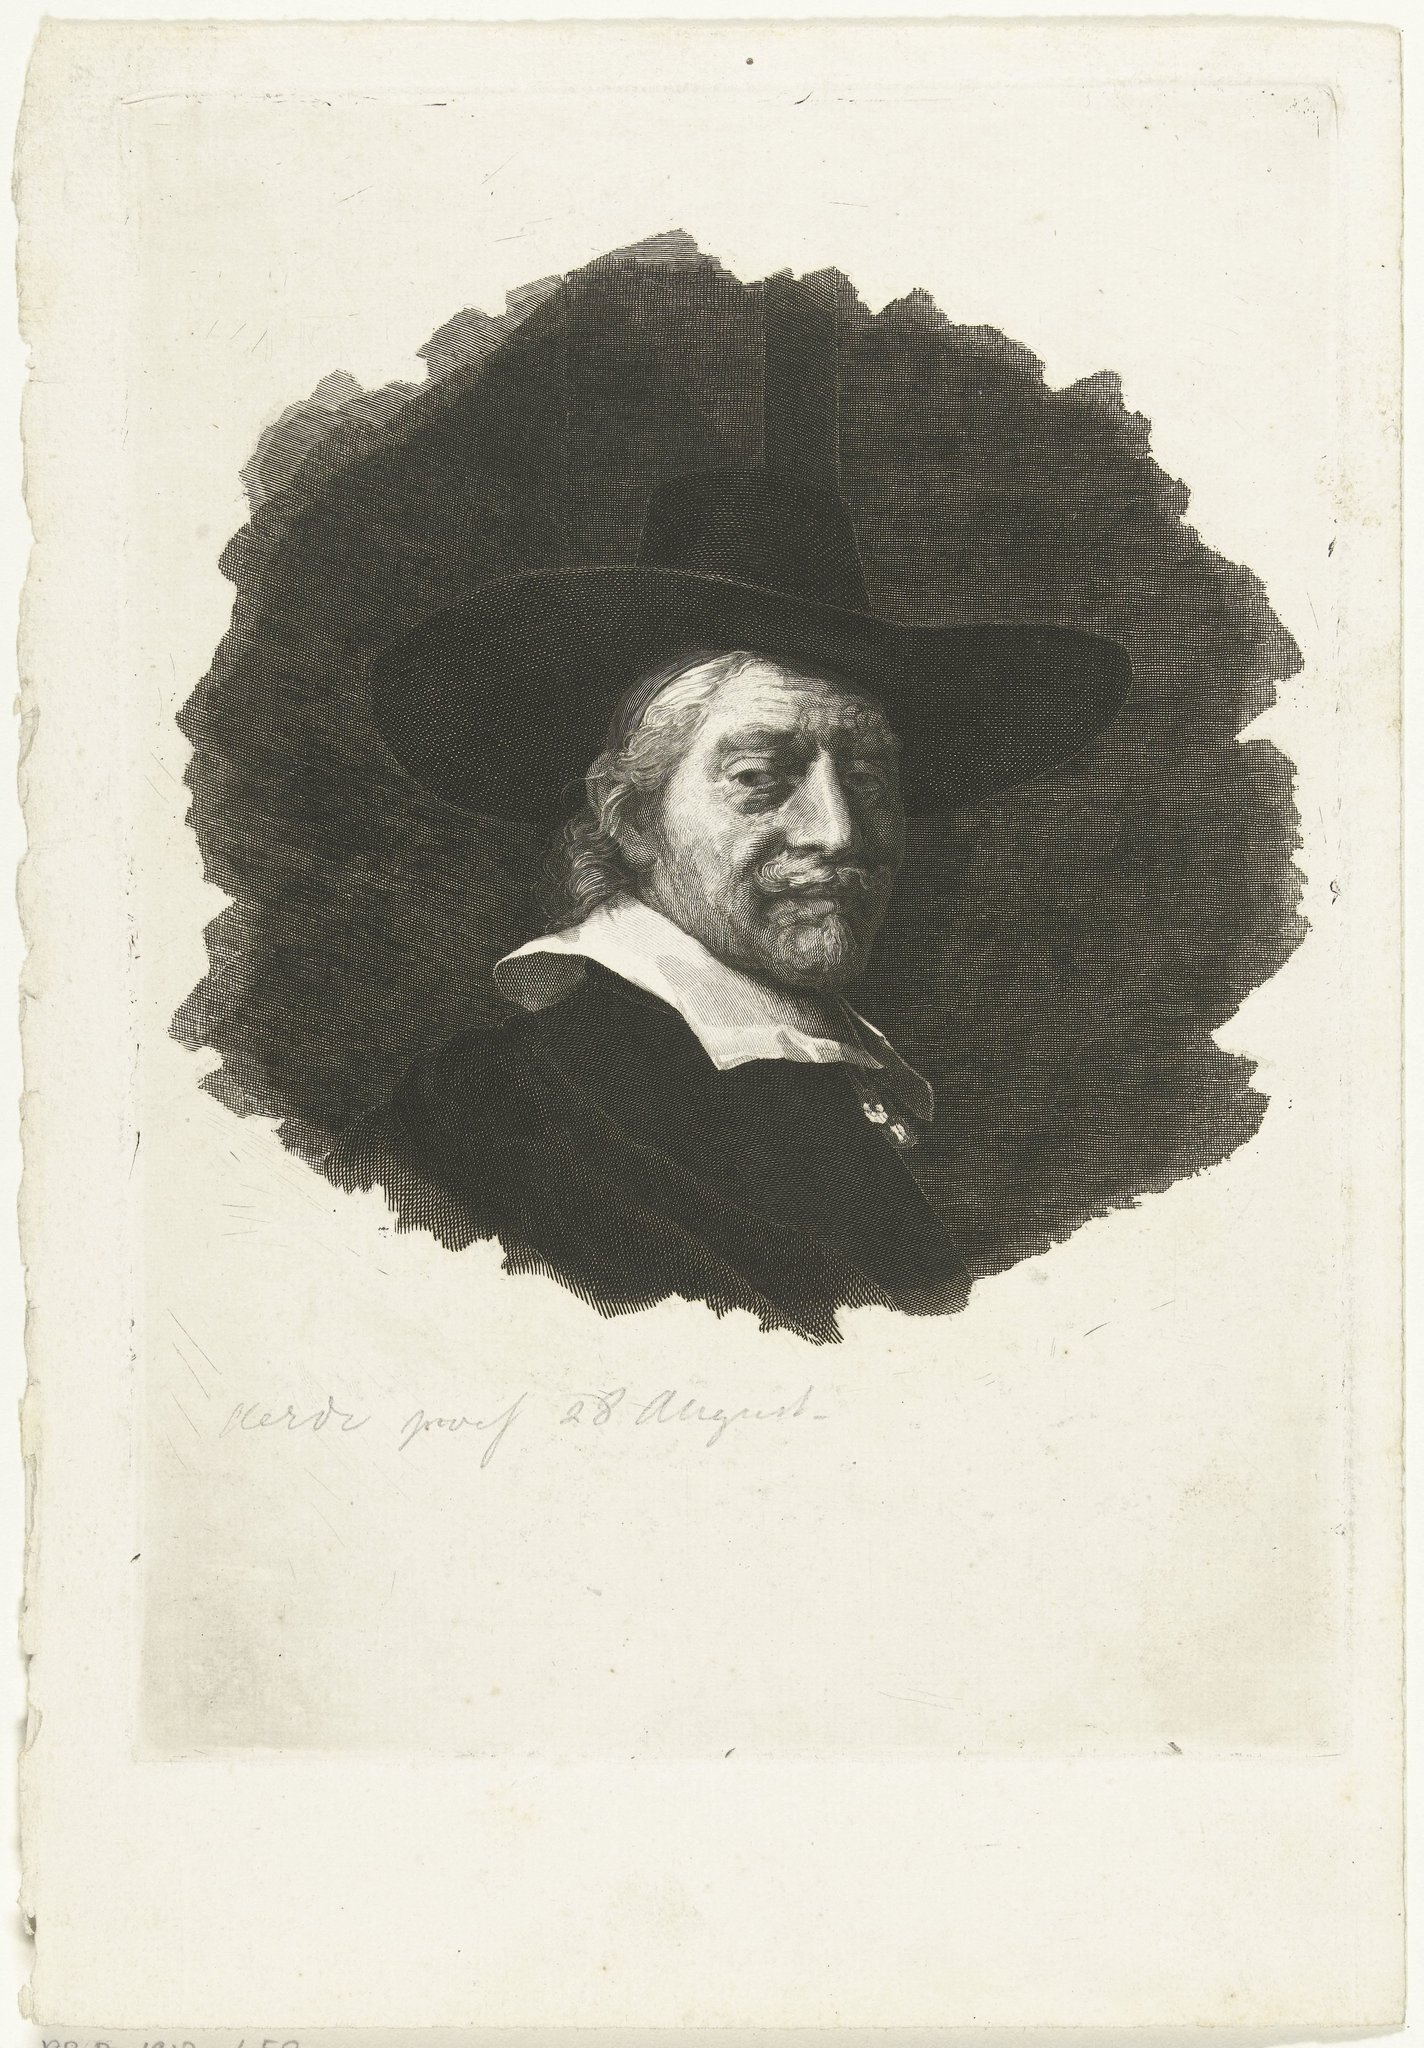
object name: print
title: Portret van een staalmeester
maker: henricus wilhelmus couwenberg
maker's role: draughtsman, print maker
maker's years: 1814-1845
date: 1834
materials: paper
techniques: engraving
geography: amsterdam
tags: anonymous historical person portrayed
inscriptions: inscription: ‘derde proef 28 august’, collector's mark: Lugt 2228